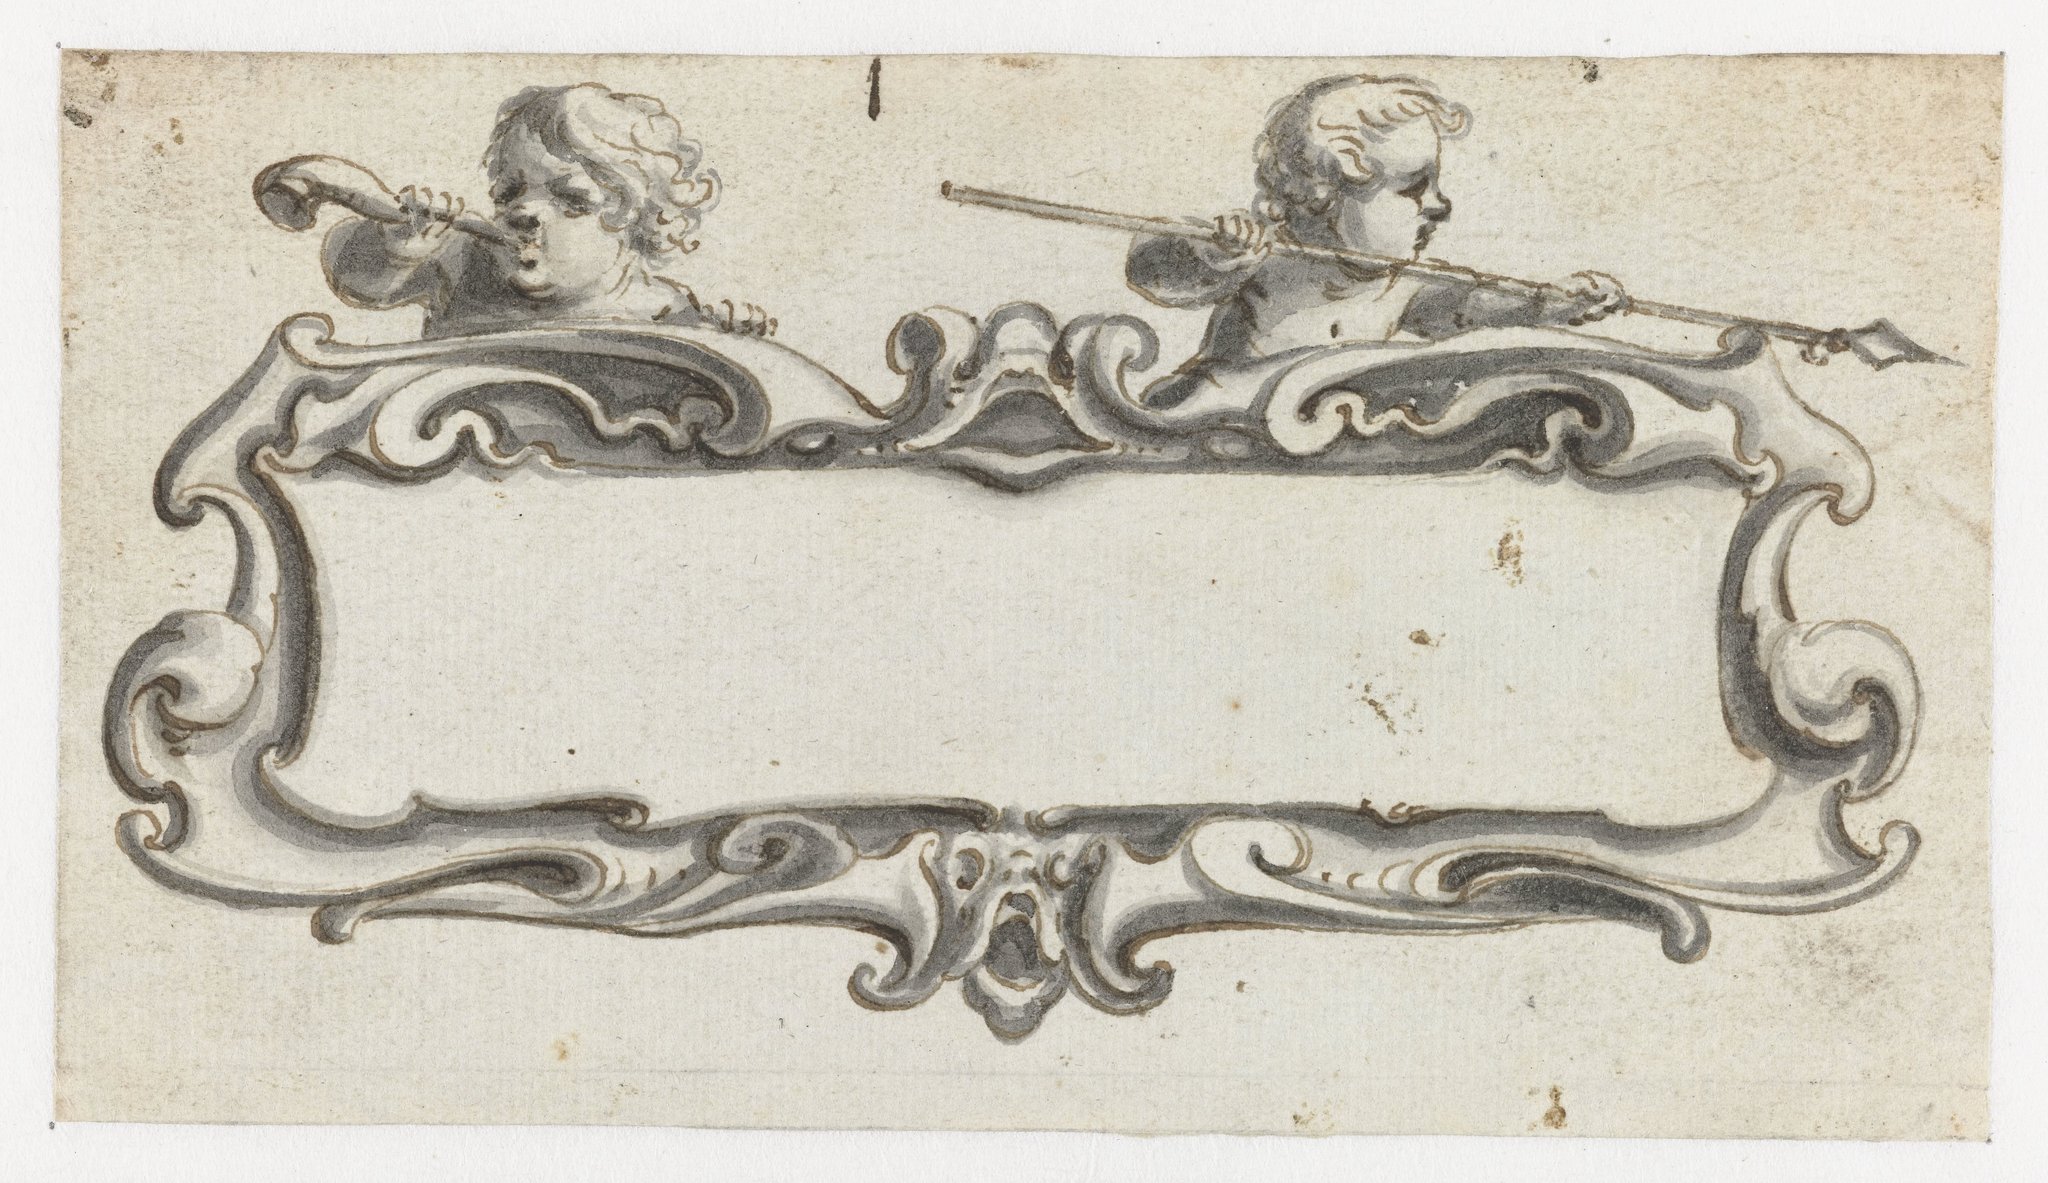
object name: design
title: Cartouche met twee jongens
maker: pieter jansz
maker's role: draughtsman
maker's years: 1602-1672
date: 1657-1662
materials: chalk, ink, paper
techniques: brush, pen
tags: ornament ~ cartouche, cupids: 'amores', 'amoretti', 'putti'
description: Cartouche met twee jongens waarvan de een een ramshoorn vastheeft en de ander een speer. Ontwerp voor een prent.